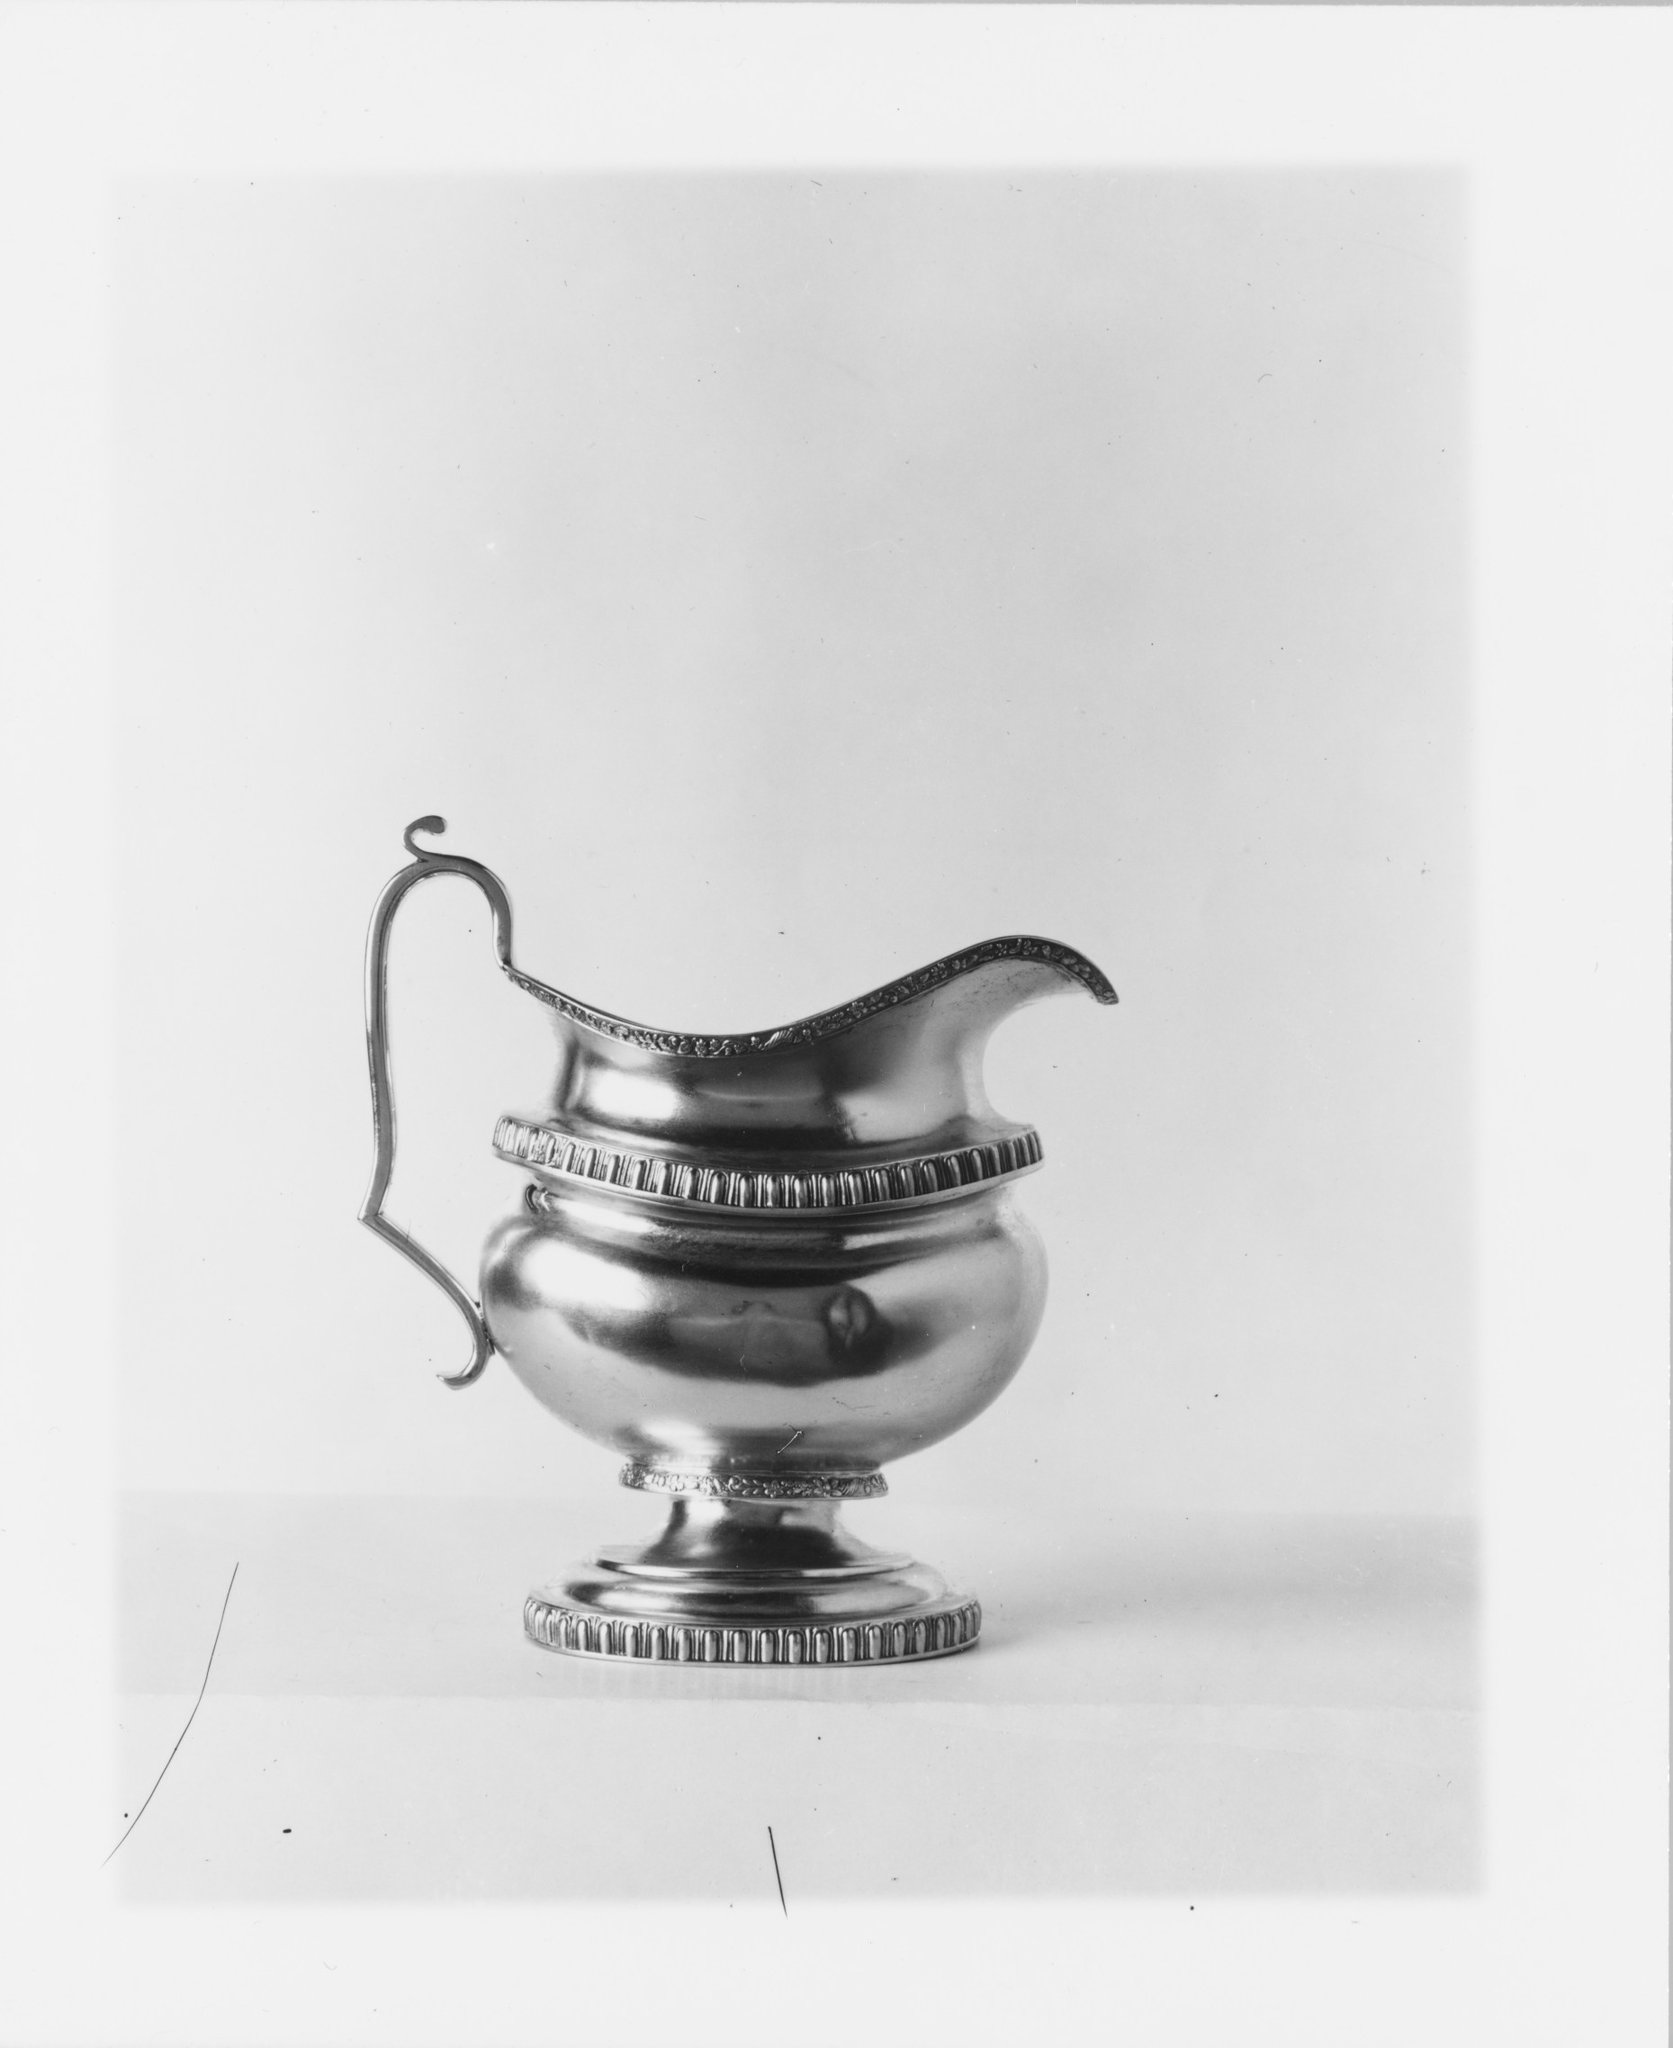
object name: cream pot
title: Creamer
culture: american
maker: garrett eoff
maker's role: maker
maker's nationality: american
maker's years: 1779-1845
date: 1825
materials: silver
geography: united states